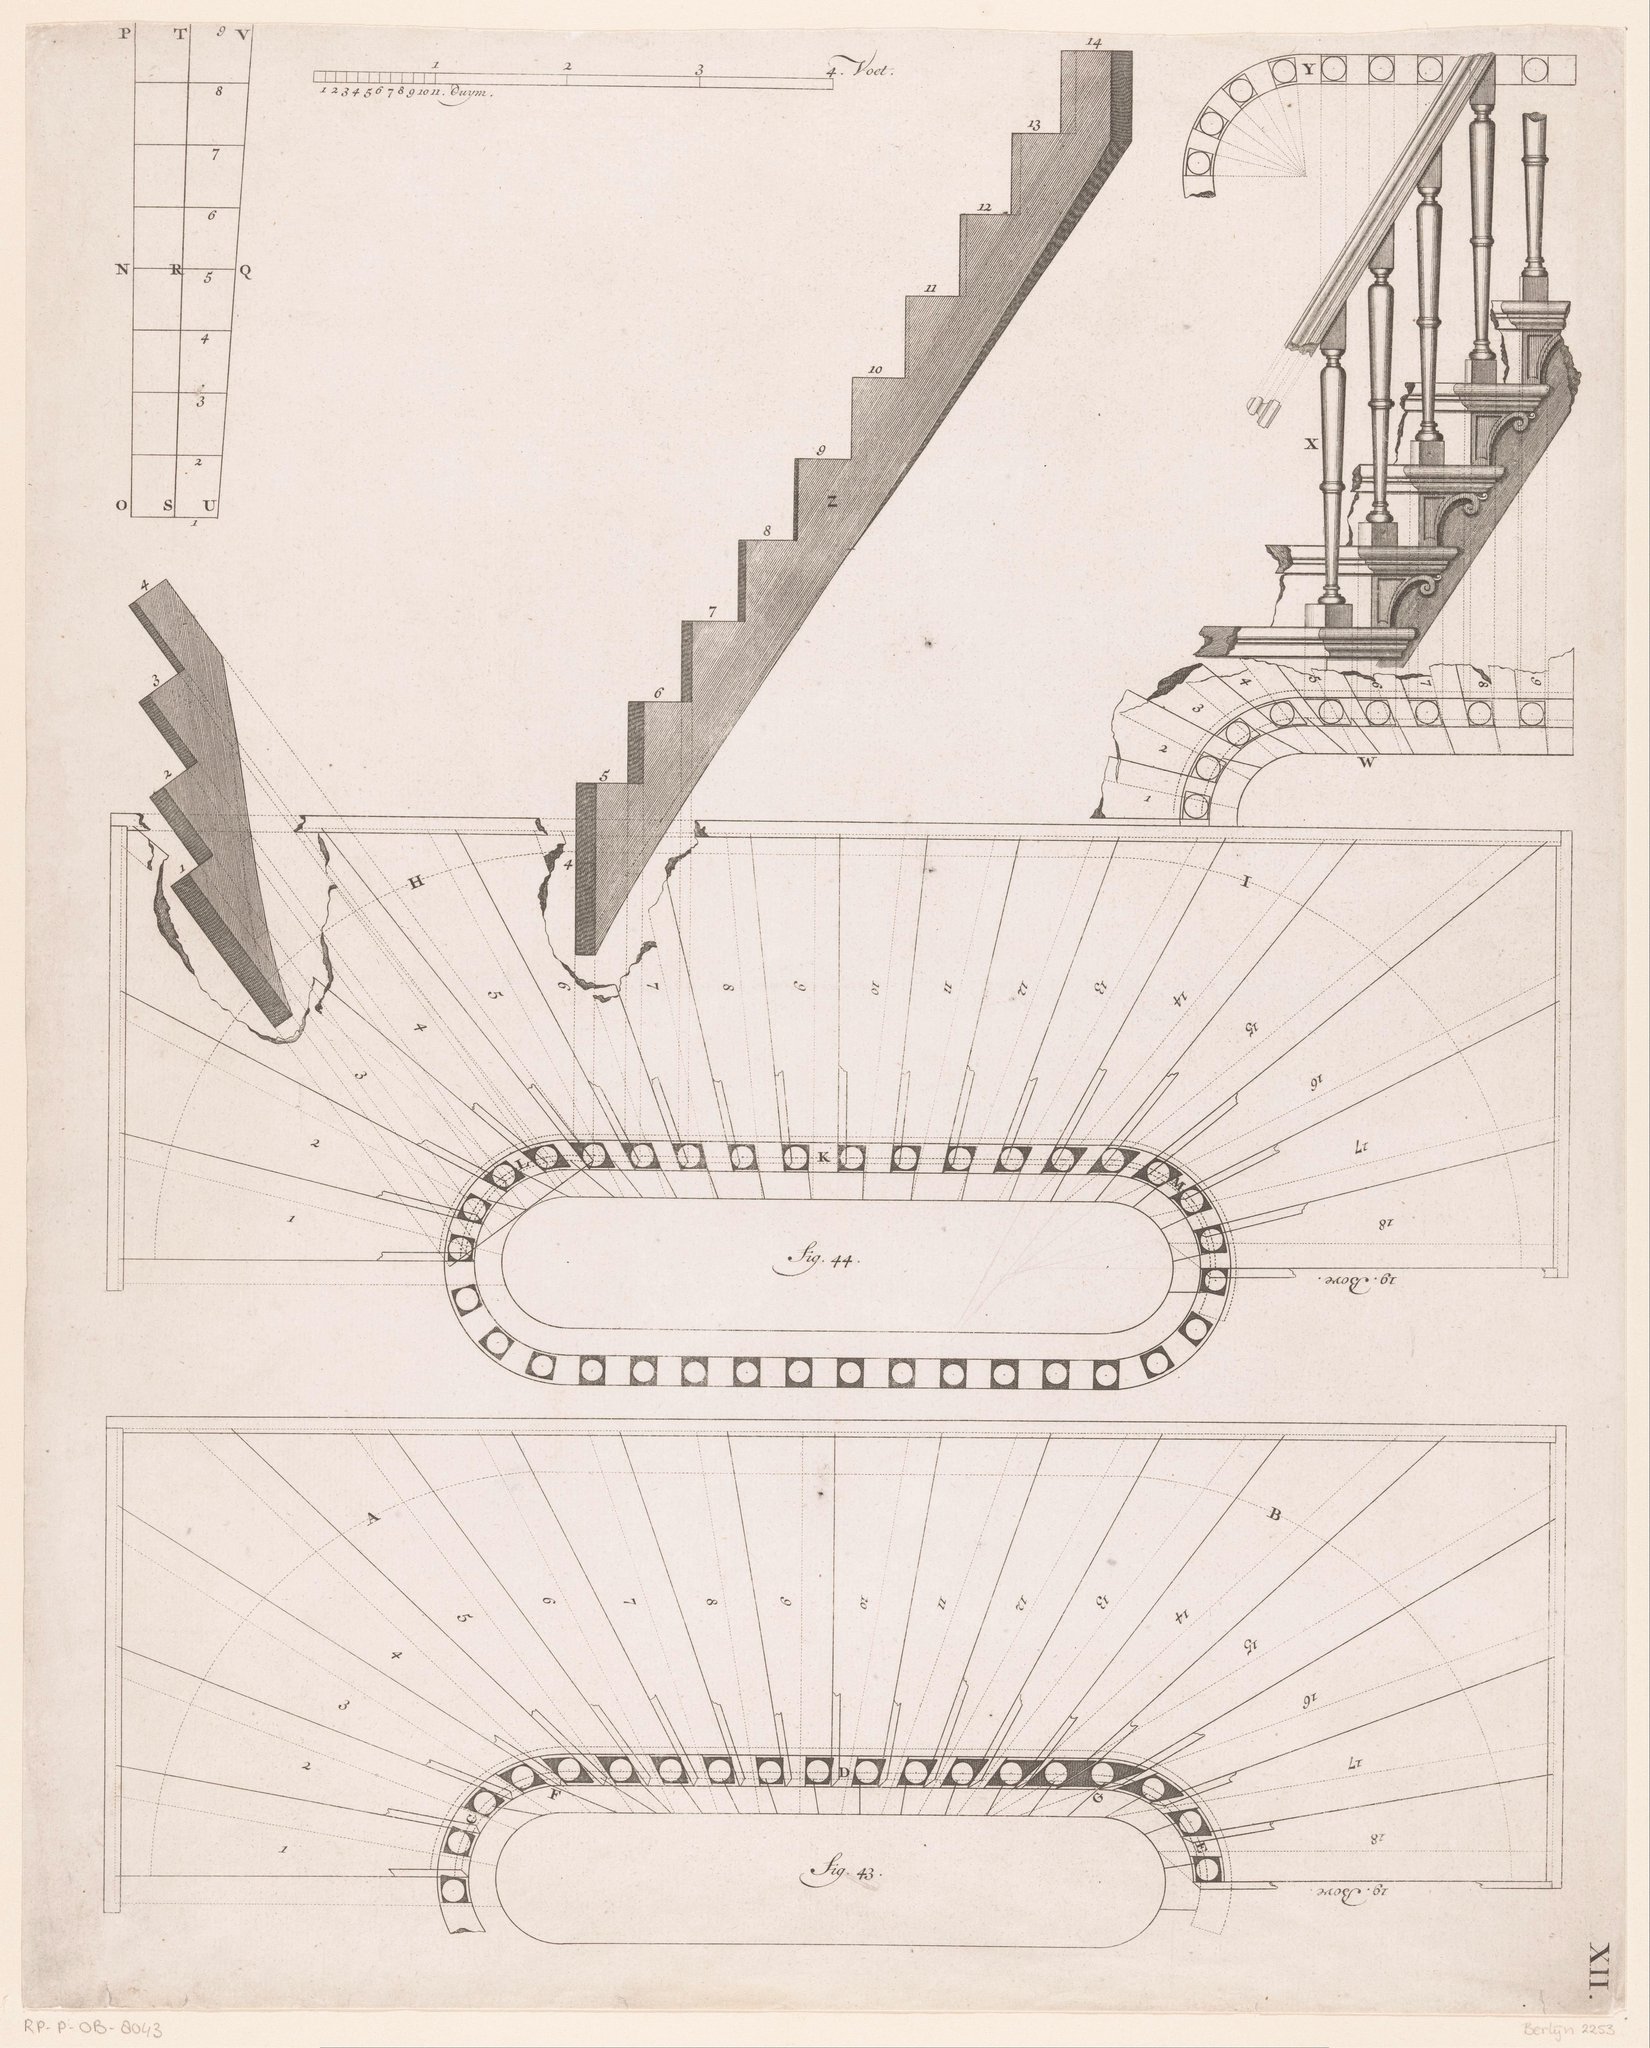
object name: print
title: Theatrum Machinarum Universale; Of Nieuwe Algemeende Bouwkunde (...)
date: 1739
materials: paper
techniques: engraving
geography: amsterdam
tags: drawing (mathematics), staircase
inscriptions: collector's mark: Lugt 2228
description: Technische tekeningen van trappen met verdreven kwarten (nummers 43 en 44). Boven- en zijaanzichten en traphek.